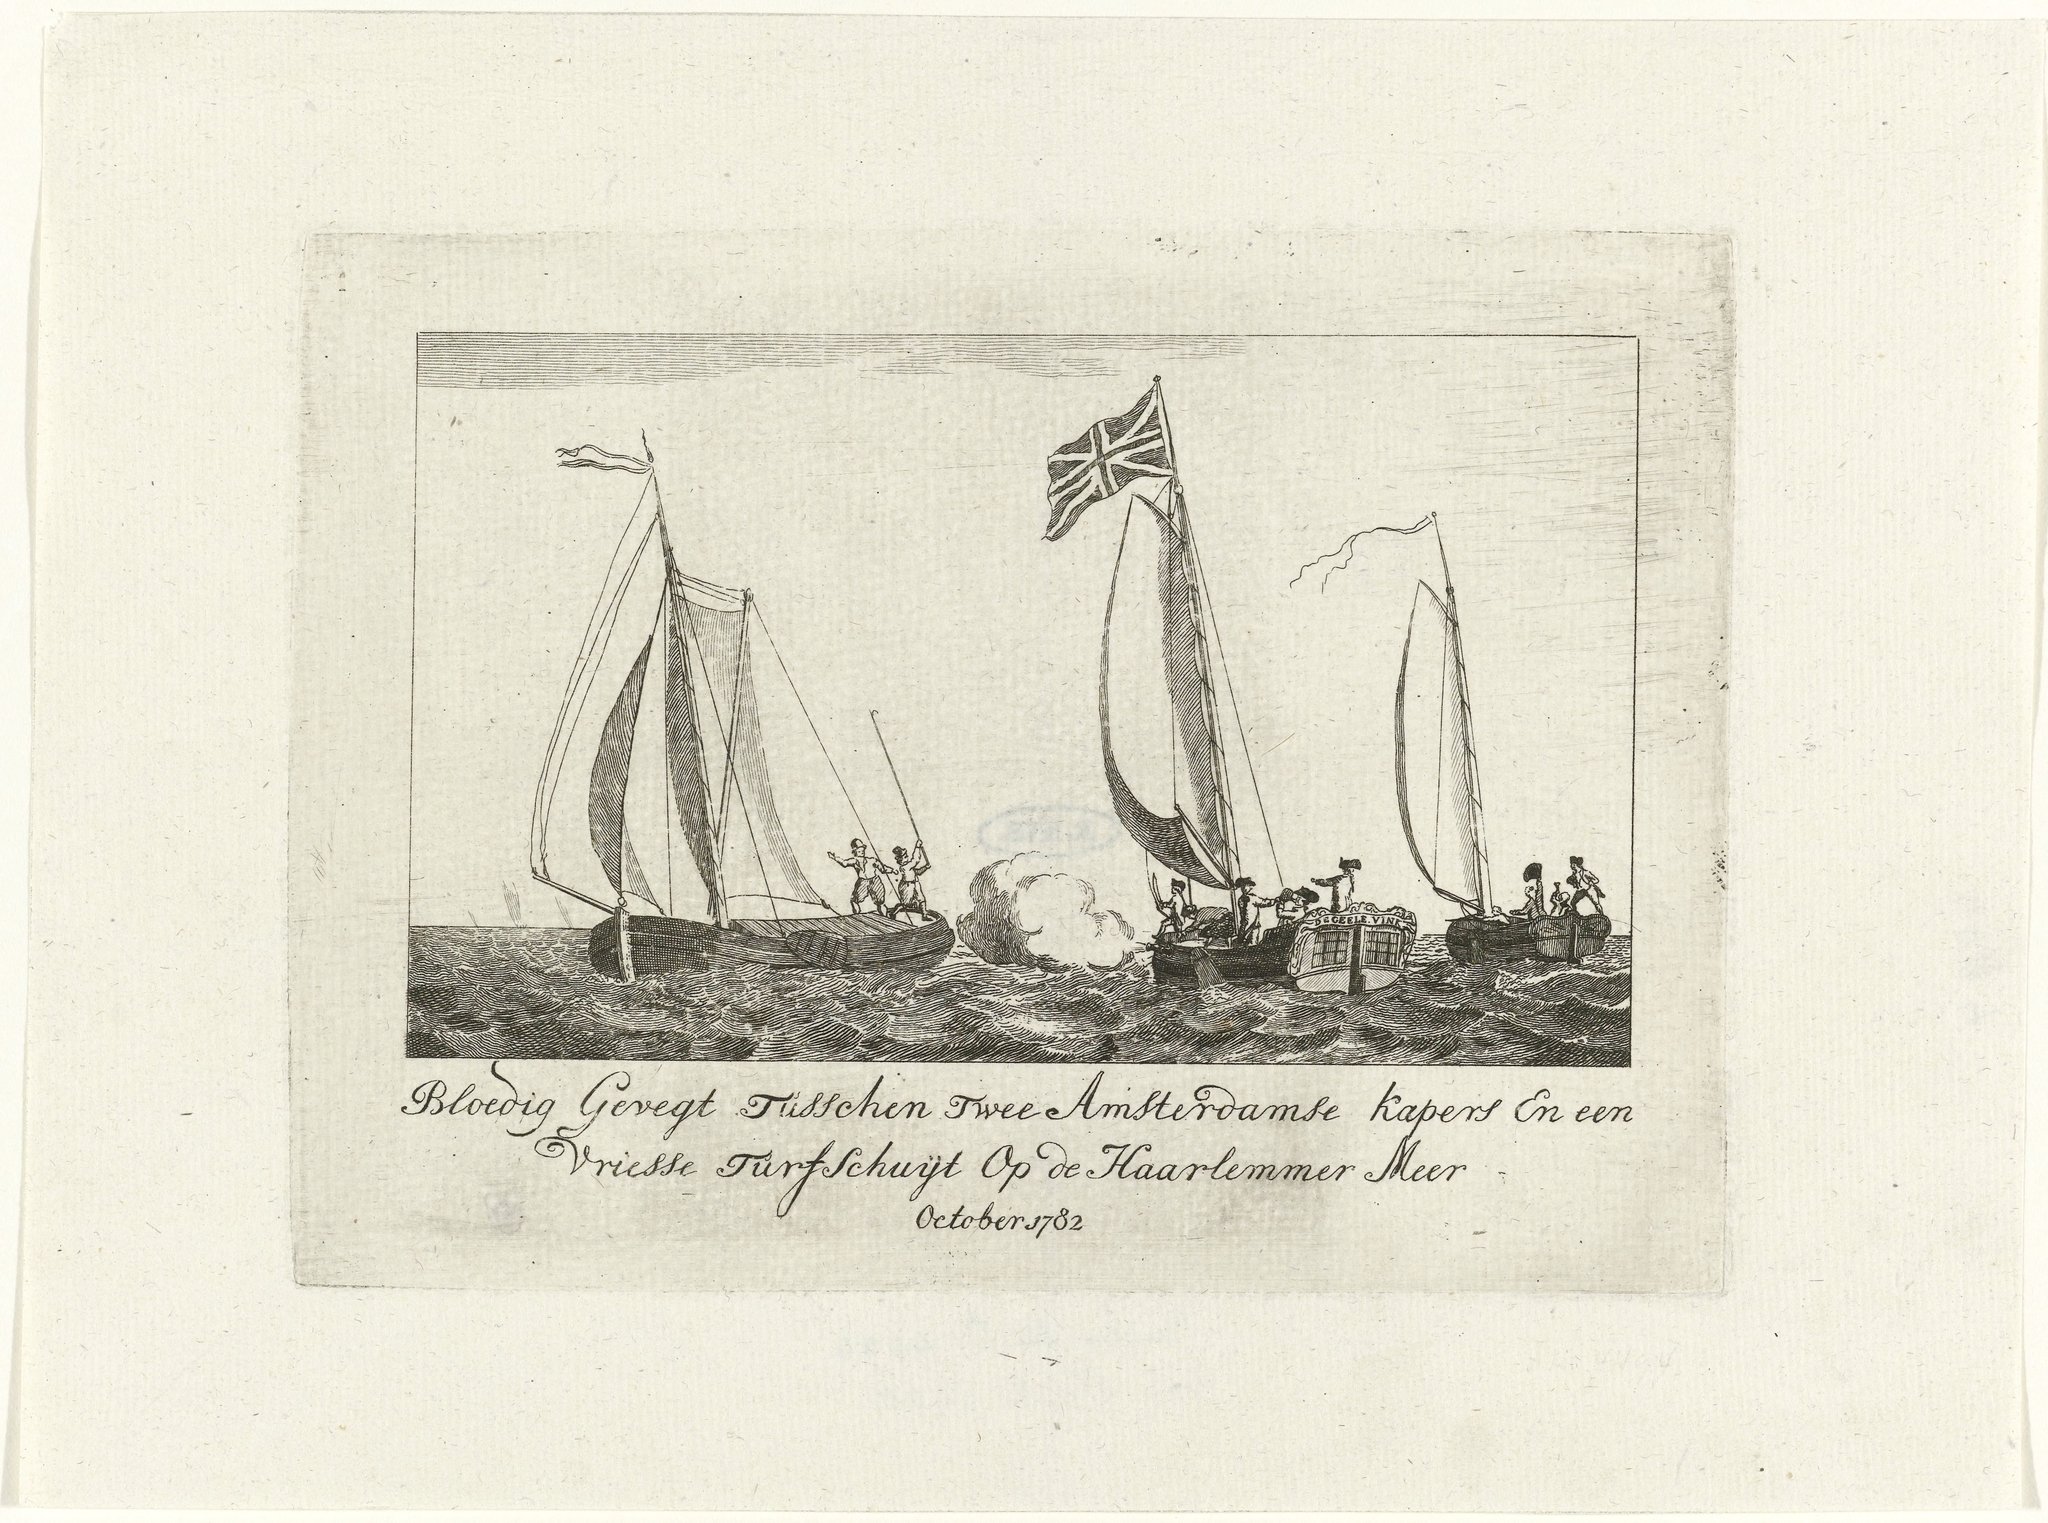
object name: print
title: Aanslag van Amsterdamse losbollen op een Fries turfschip, 1782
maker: Anonymous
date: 1782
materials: paper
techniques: etching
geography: northern netherlands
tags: battle (+ naval force)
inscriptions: collector's mark: Lugt 2228, collector's mark: Lugt 2760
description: Aanval gepleegd door drie Amsterdamse losbollen (Geelvink, Van Welderen en Peterson) met hun jacht De Gele Vink op een Fries turfschip op de Haarlemmermeer, oktober 1782. Op het jacht is de Britse vlag gehesen.